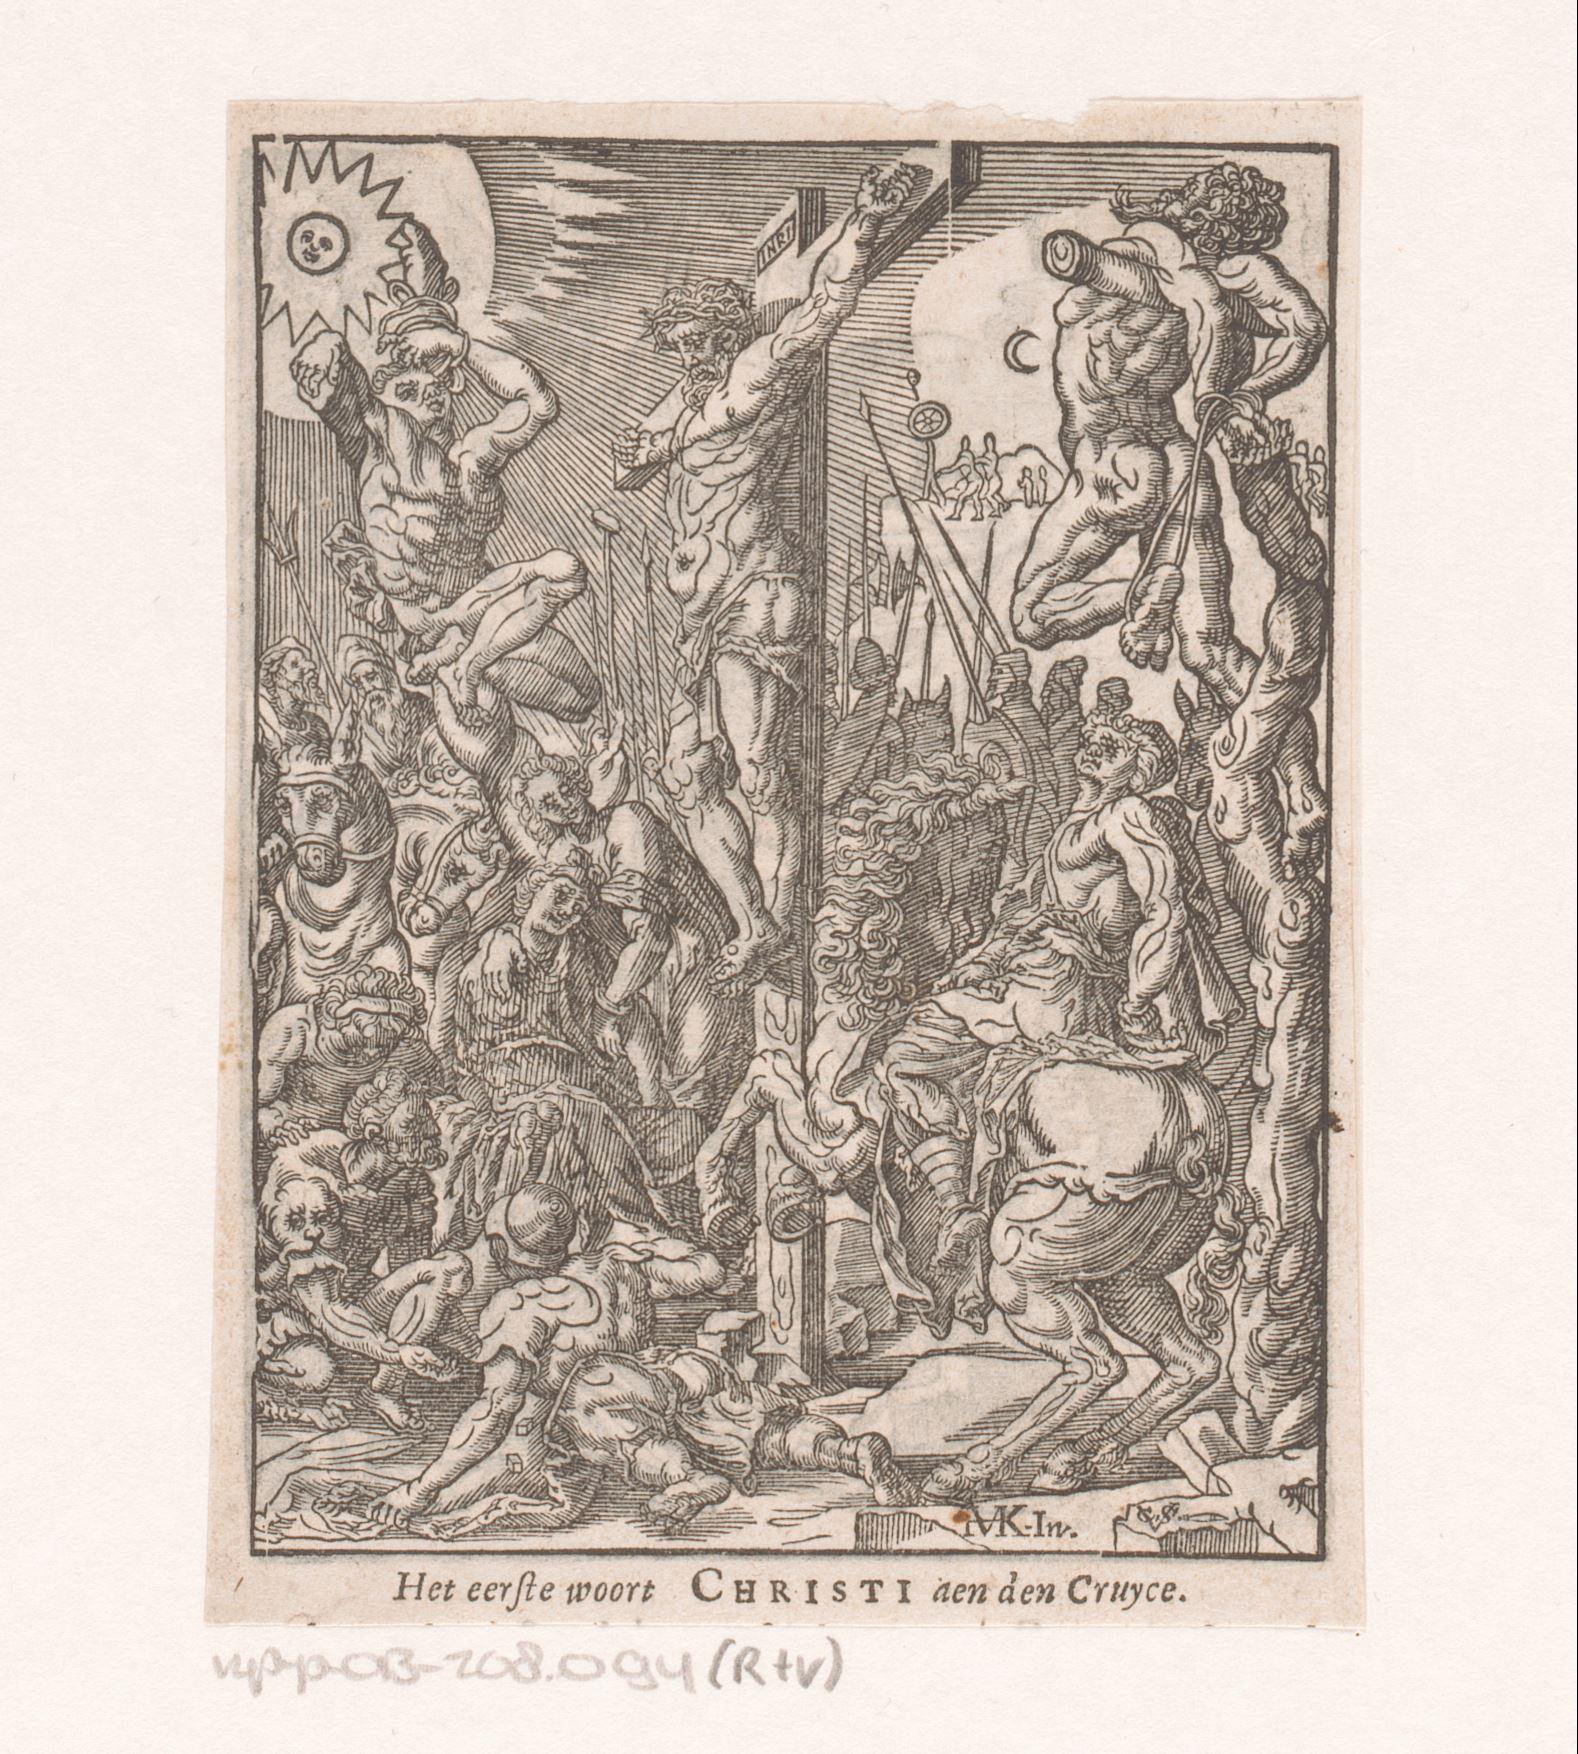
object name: print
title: Christus aan het kruis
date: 1648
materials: paper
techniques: letterpress printing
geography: haarlem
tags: crucified christ with stephaton and/or longinus - dd - the three crosses, sun and moon in the sky at either side of the cross of christ, the crucifixion of christ: christ's death on the cross; golgotha (matthew 27:45-58; mark 15:33-45; luke 23:44-52; john 19:25-38)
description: Prent uit: 't Schat der Zielen, dat is, het geheele leven ons Heeren Iesu Christi naer de vyer Evangelisten (...) in zeven stucken verdeelt. Amsterdam: Pieter Jacobsz. Paets, 1648. Deze prent komt uit het vijfde deel of hoofdstuk van 't Schat der zielen: Passie ons Heeren Iesu Christi, naer de beschrijvinghe van de vier evangelisten. Binnen het vijfde deel hoort deze prent bij de beschrijving van de passie door Lucas.